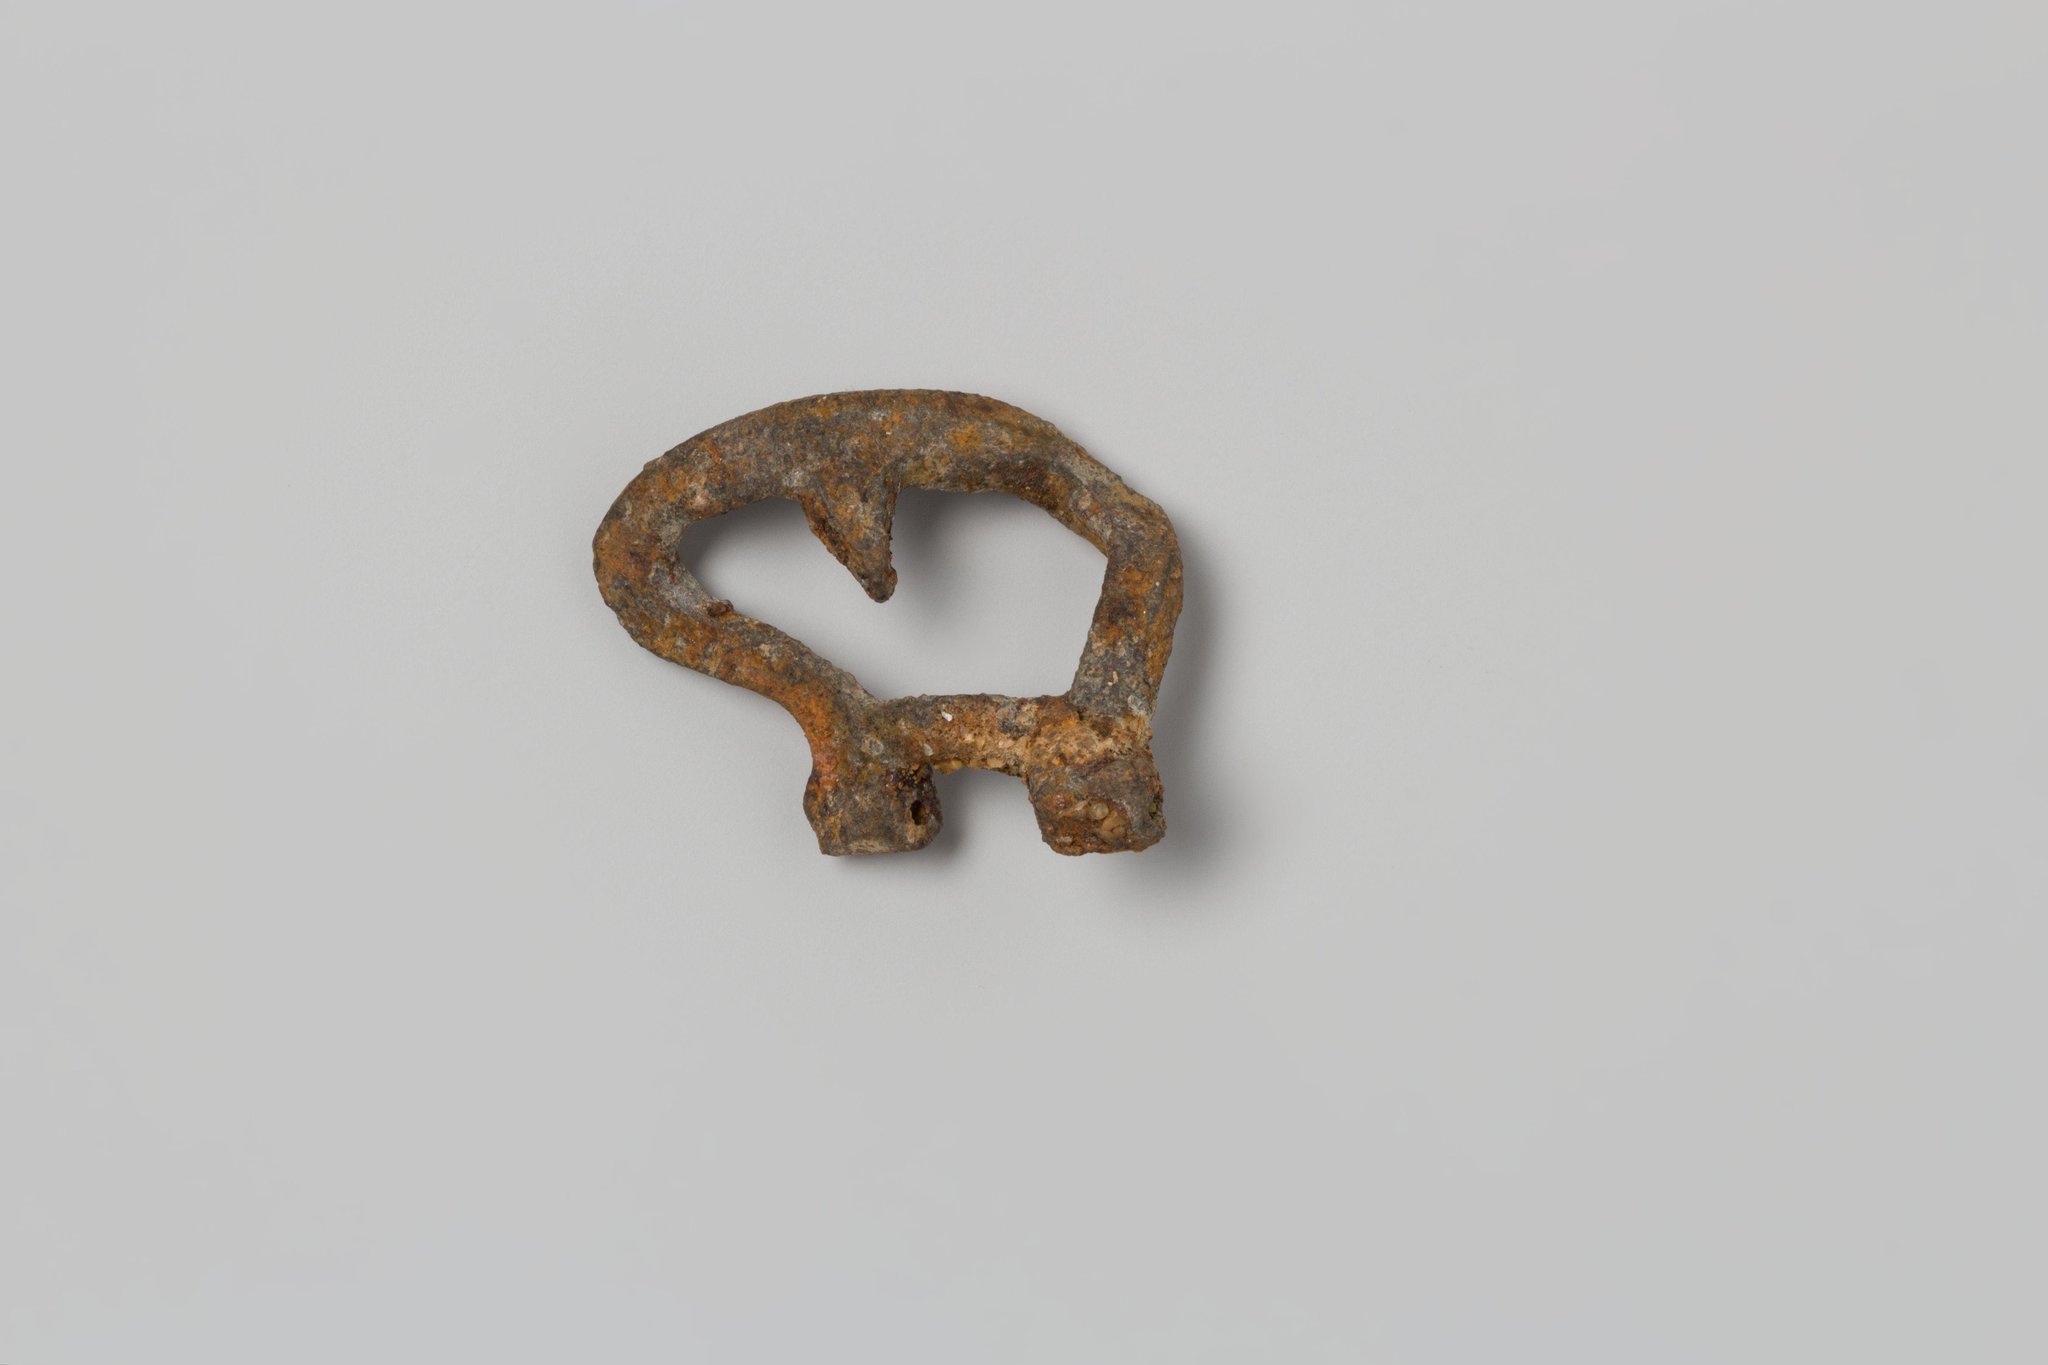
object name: buckle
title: Gesp uit het wrak van de Oost-Indiëvaarder Hollandia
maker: Anonymous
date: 1700-1743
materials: tin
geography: netherlands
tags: verenigde oostindische compagnie, hollandia (schip), annet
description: Buckle, chape buckle, chape; loop squashed, single-pronged, no marks.